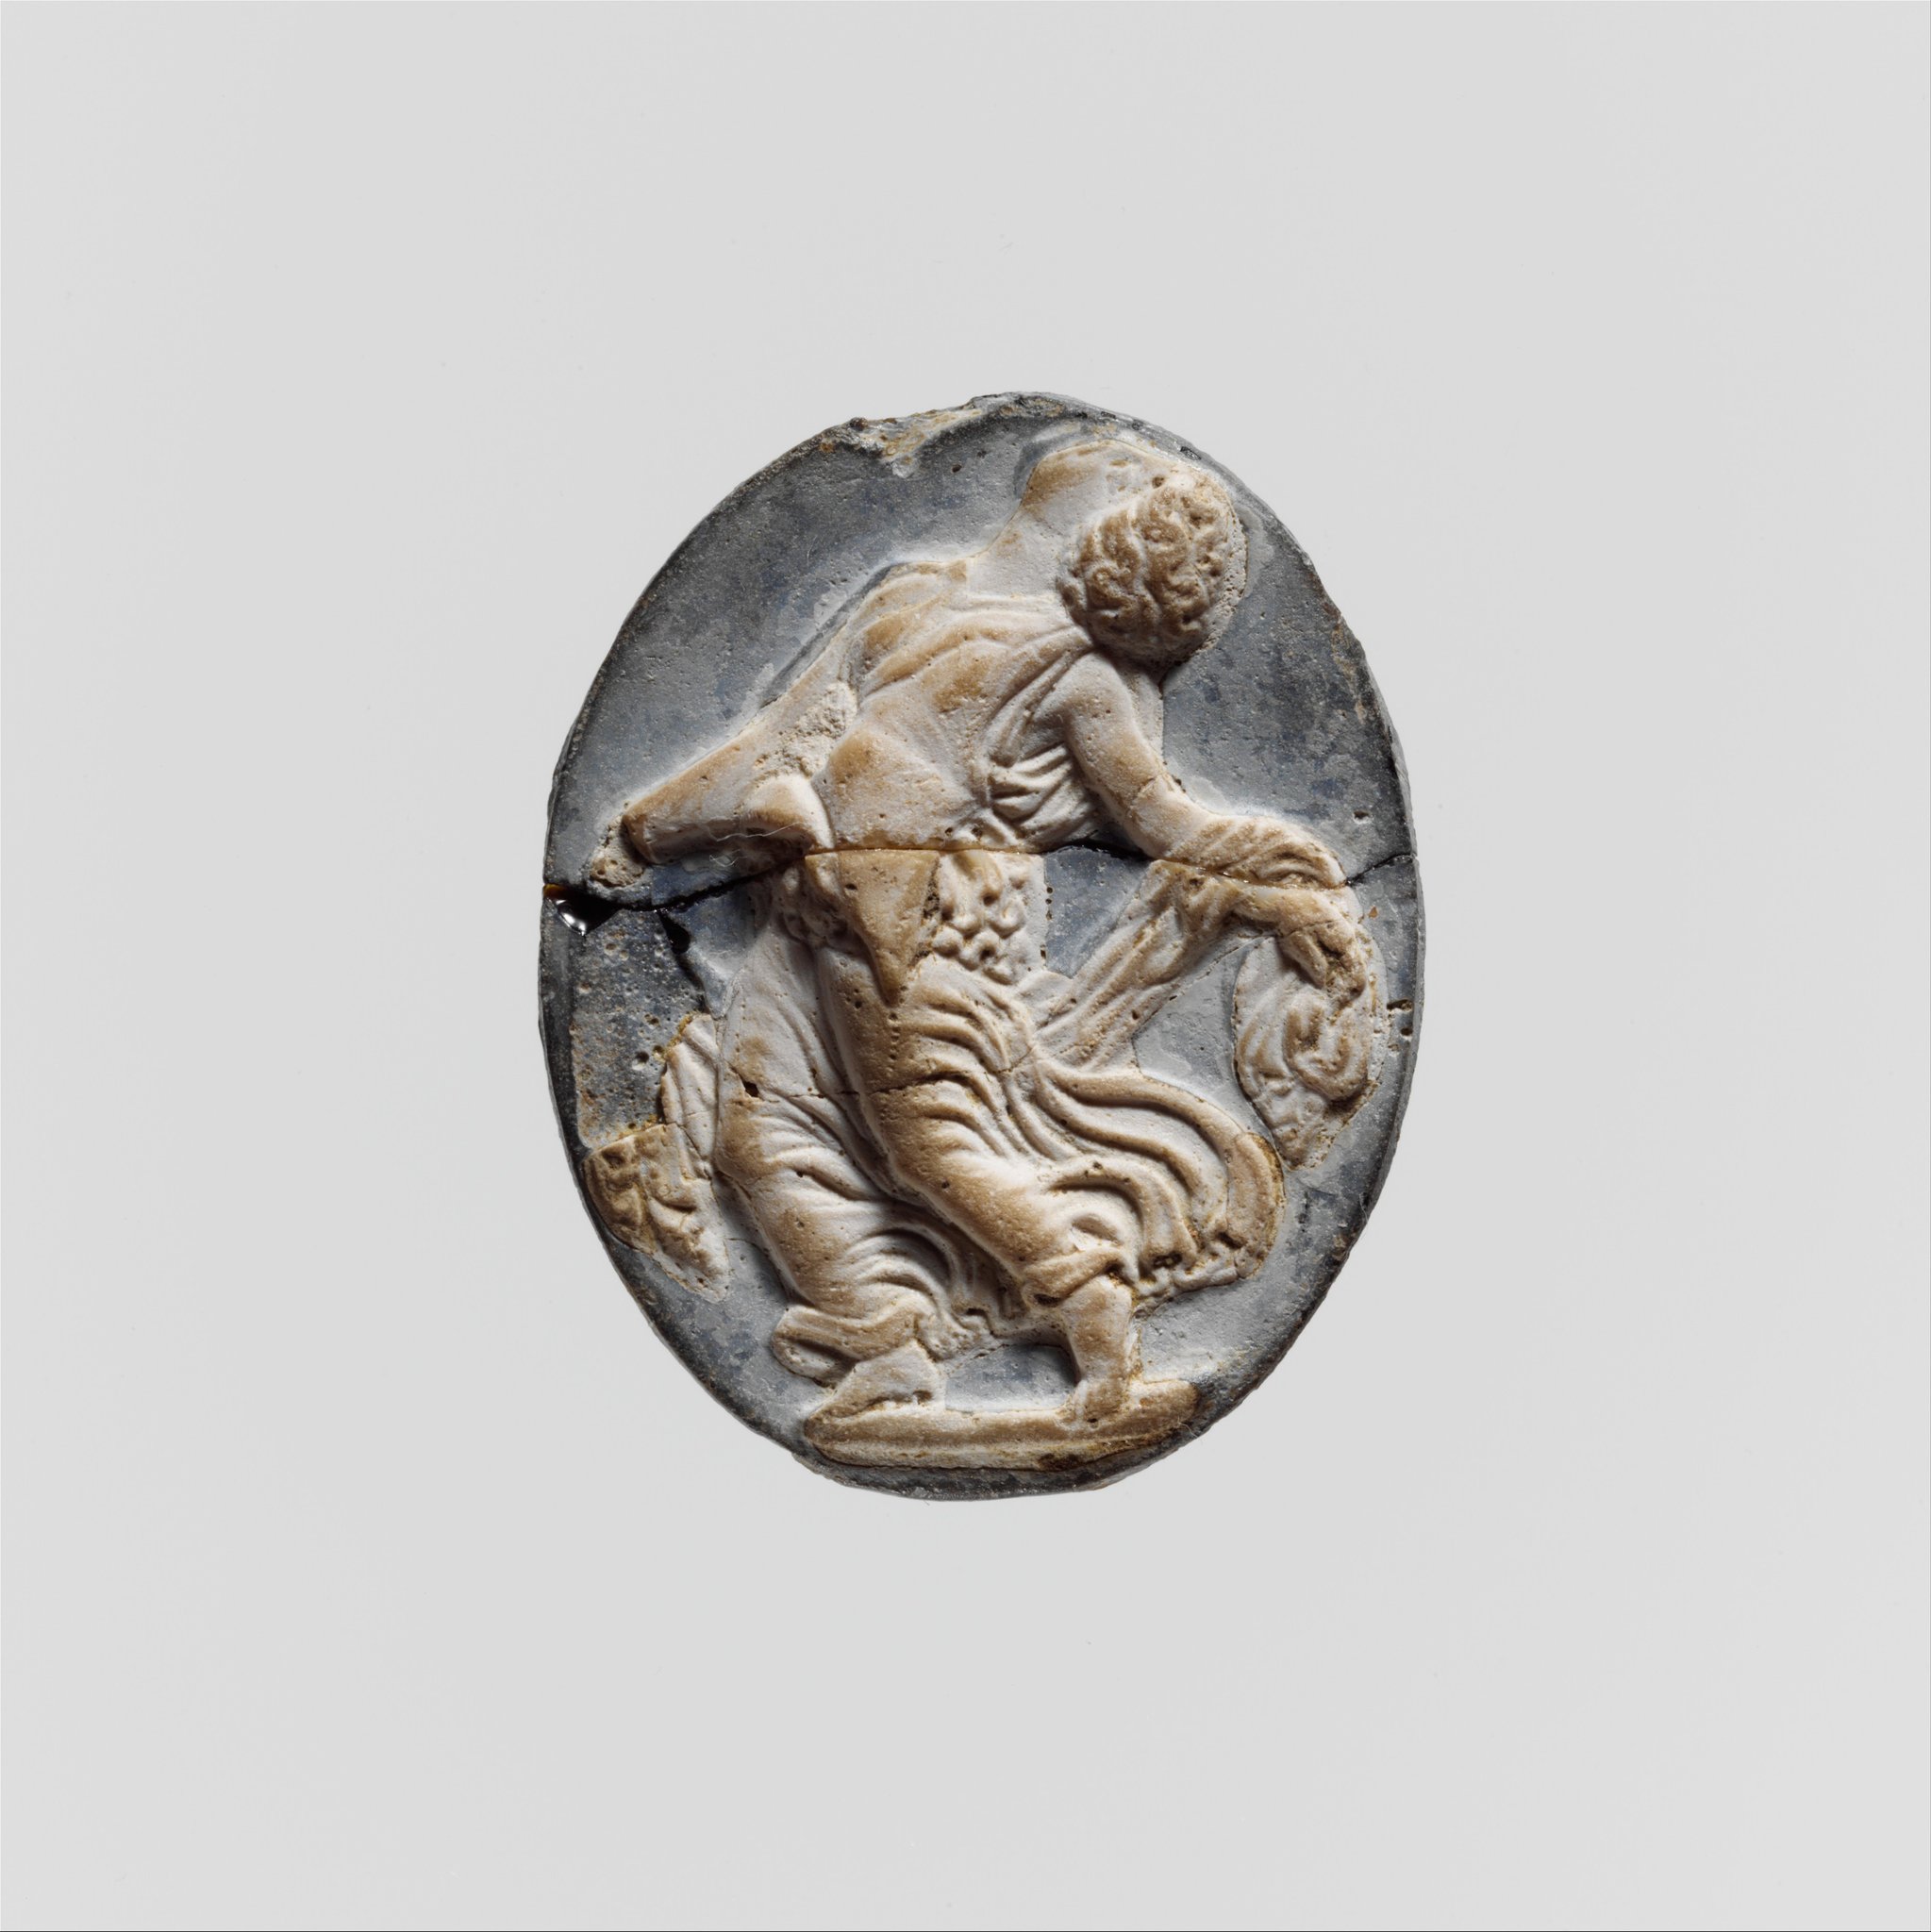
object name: cameo medallion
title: Cameo glass medallion of a maenad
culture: roman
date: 1-100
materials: glass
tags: maenads